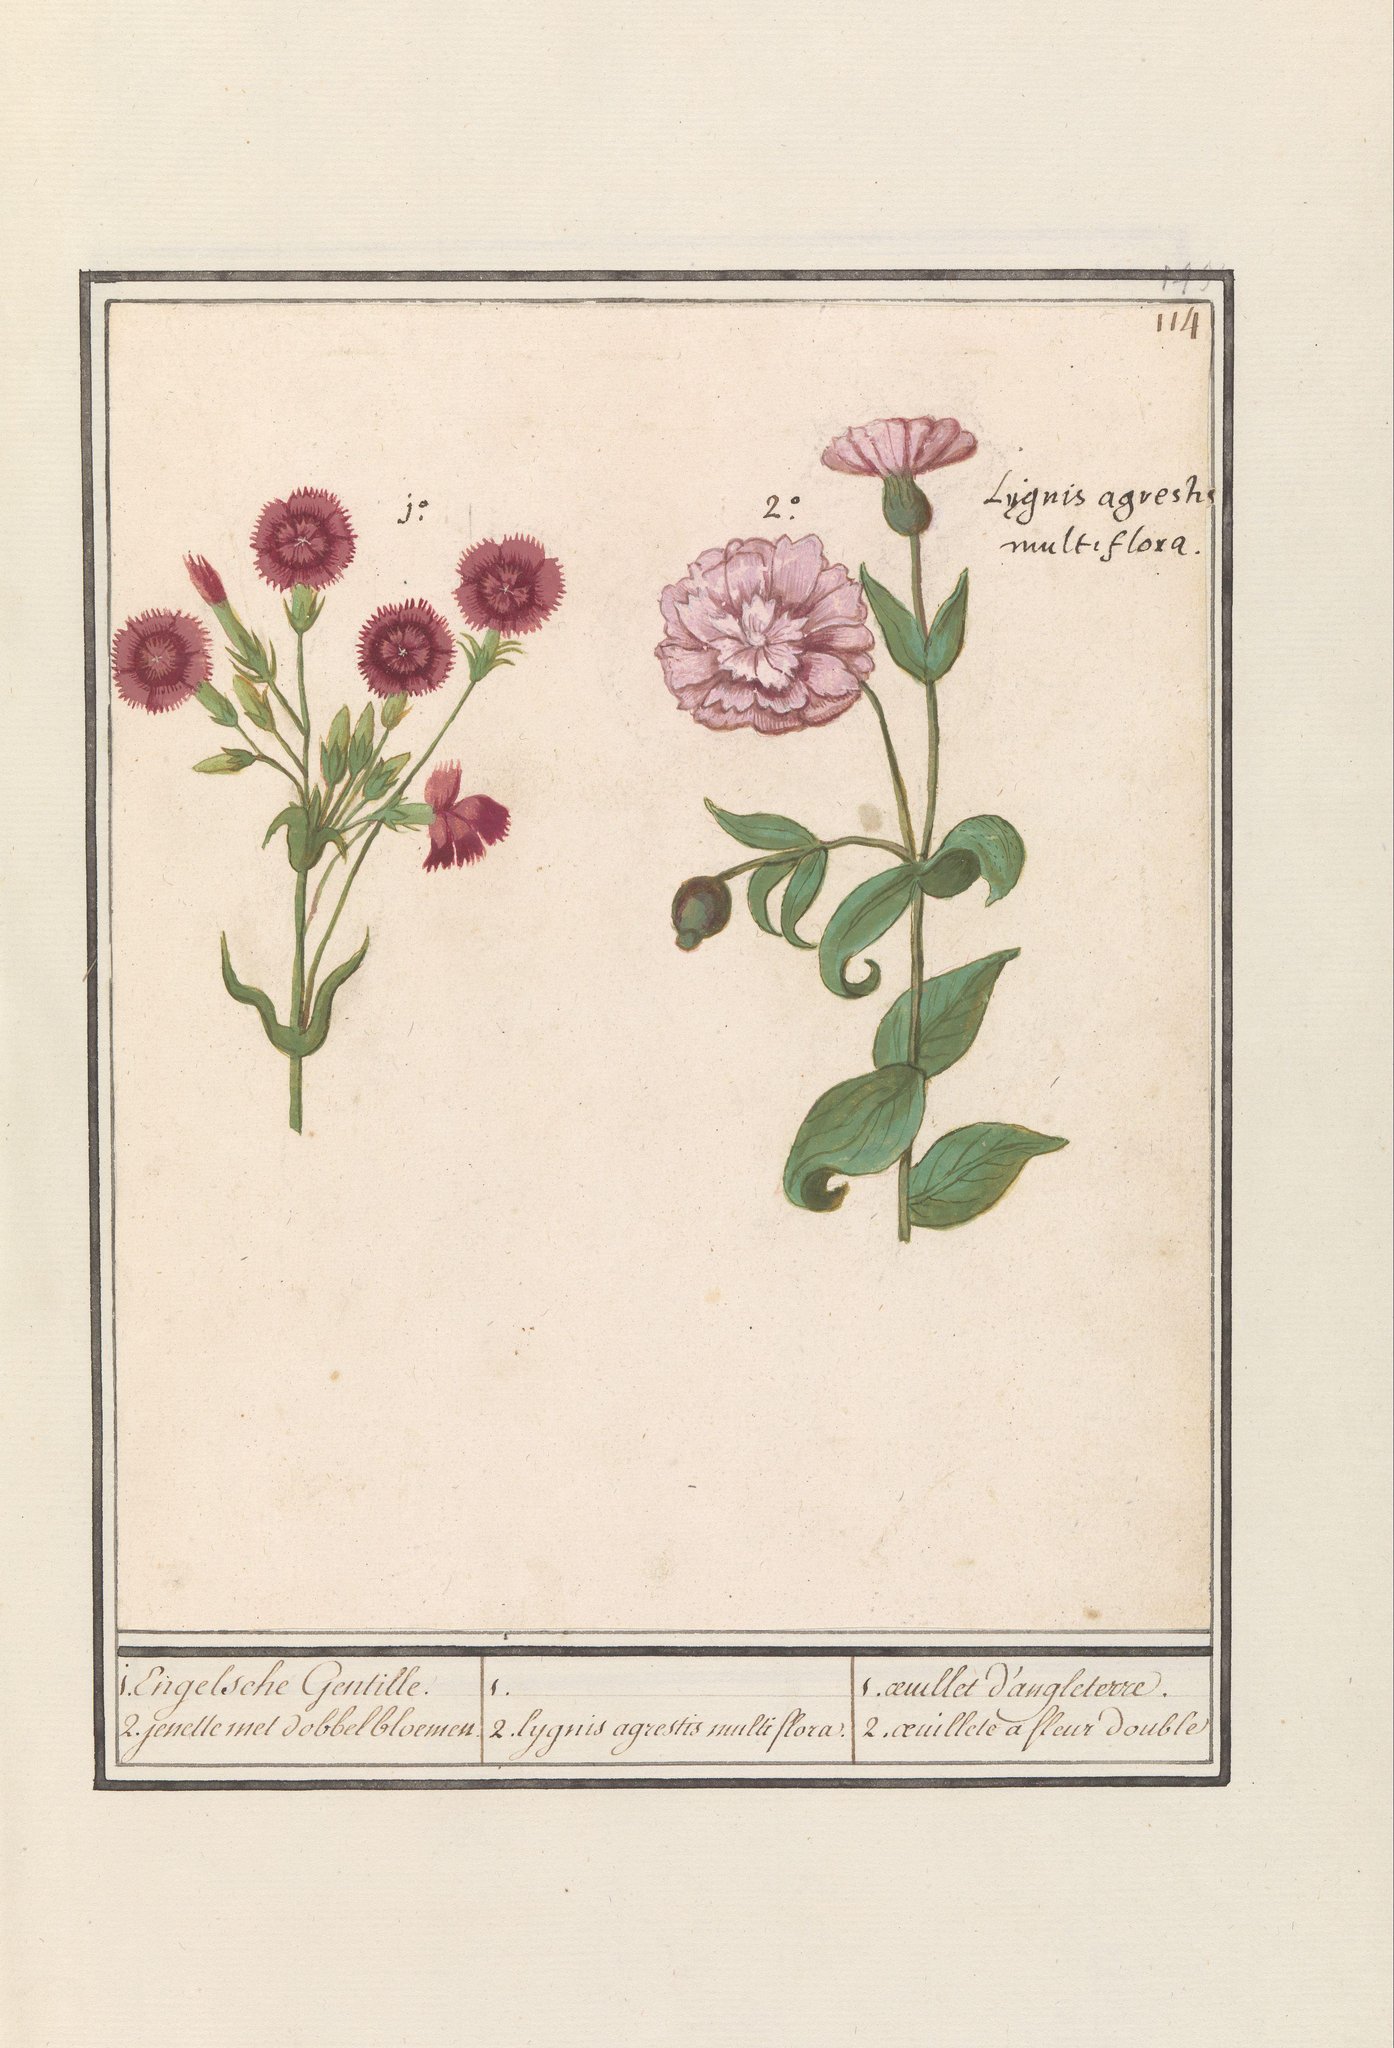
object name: drawing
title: 1. Engelsche Gentille. 2. jenelle met dobbelbloemen / 1. 2. Lygnis agrestis multiflora. / 1. oeuillet d'angleterre. 2. aeuillete a fleur double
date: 1596-1610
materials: paint, ink, paper, watercolor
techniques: brush, pen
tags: flowers: carnation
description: Twee soorten anjers. Rechtsboven genummerd: 114. Met de Latijnse naam. Onderdeel van het tweede album met tekeningen van bloemen en planten. Negende van twaalf albums met tekeningen van dieren, vogels en planten bekend rond 1600, gemaakt in opdracht van keizer Rudolf II. Met toelichting in Nederlands, Latijn en Frans.